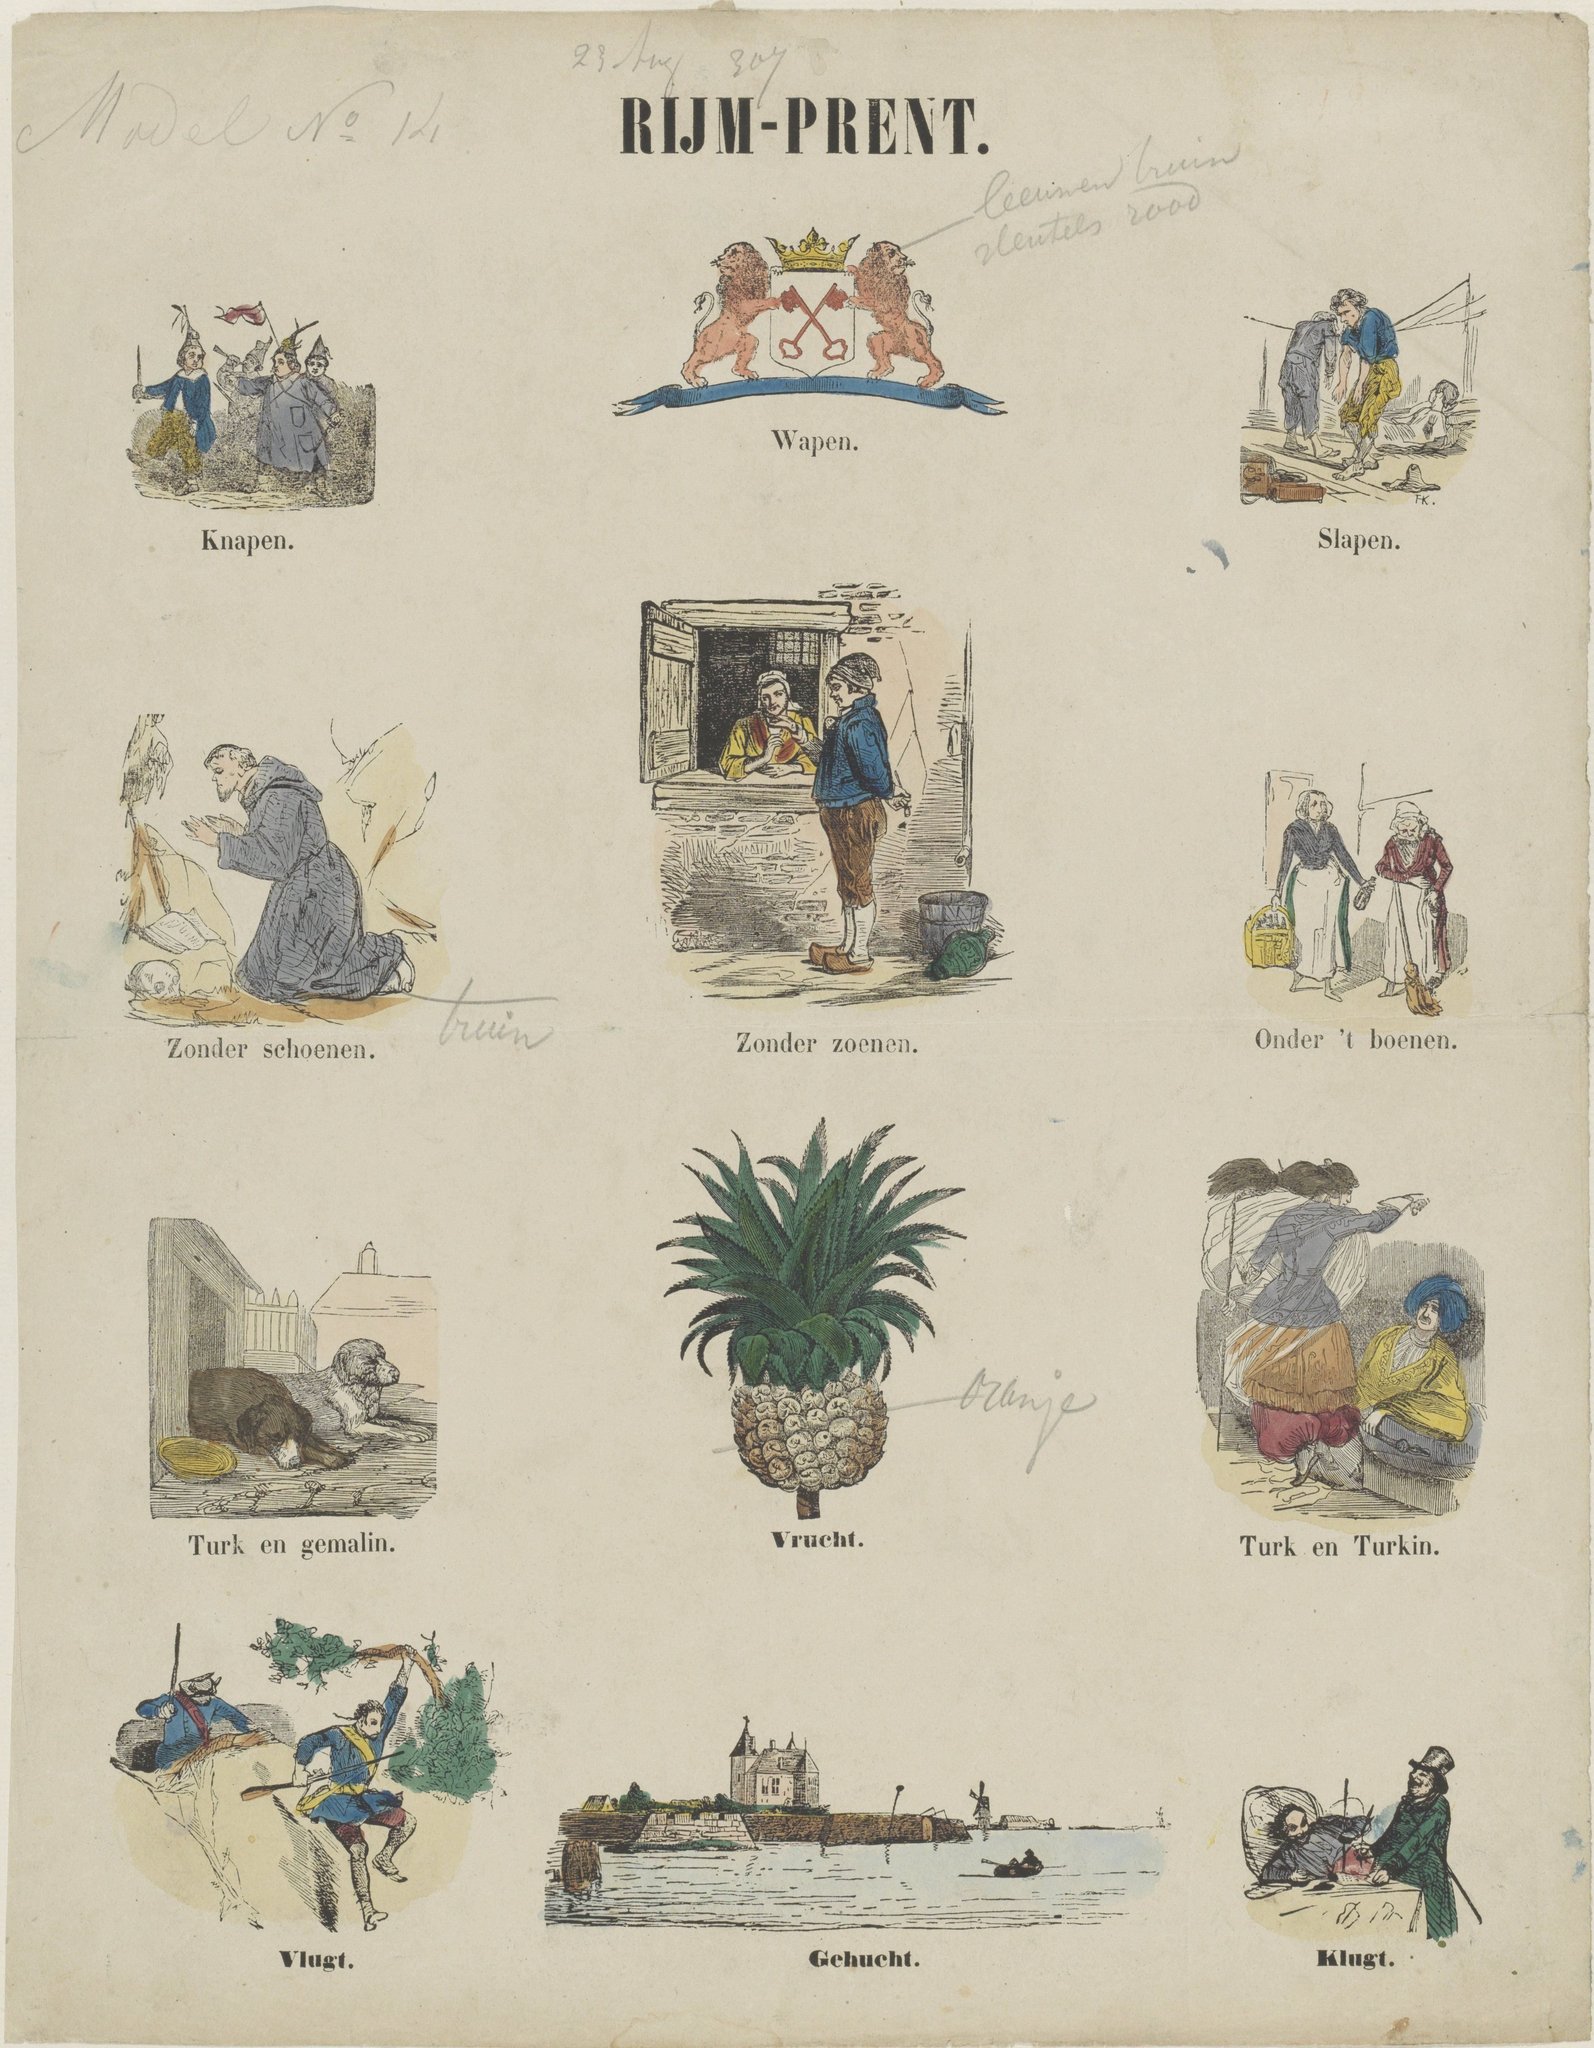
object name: popular print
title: Rijm-prent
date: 1861-1929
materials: paper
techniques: colour, letterpress printing, engraving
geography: leiden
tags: asiatic races and peoples: turks, human types, fruits: pineapple, letters, alphabet, script, child, characters (human types), dog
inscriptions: collector's mark: Lugt 2760, inscription: ‘Nadel No 14 / 23 Aug 307 / leeuwen bruin / sleutels rood / bruin / oranje’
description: Blad met 12 voorstellingen van verschillende aard waarvan de woorden rijmen, zoals knapen, wapen en slapen. Onder elke voorstelling een onderschrift in boekdruk.